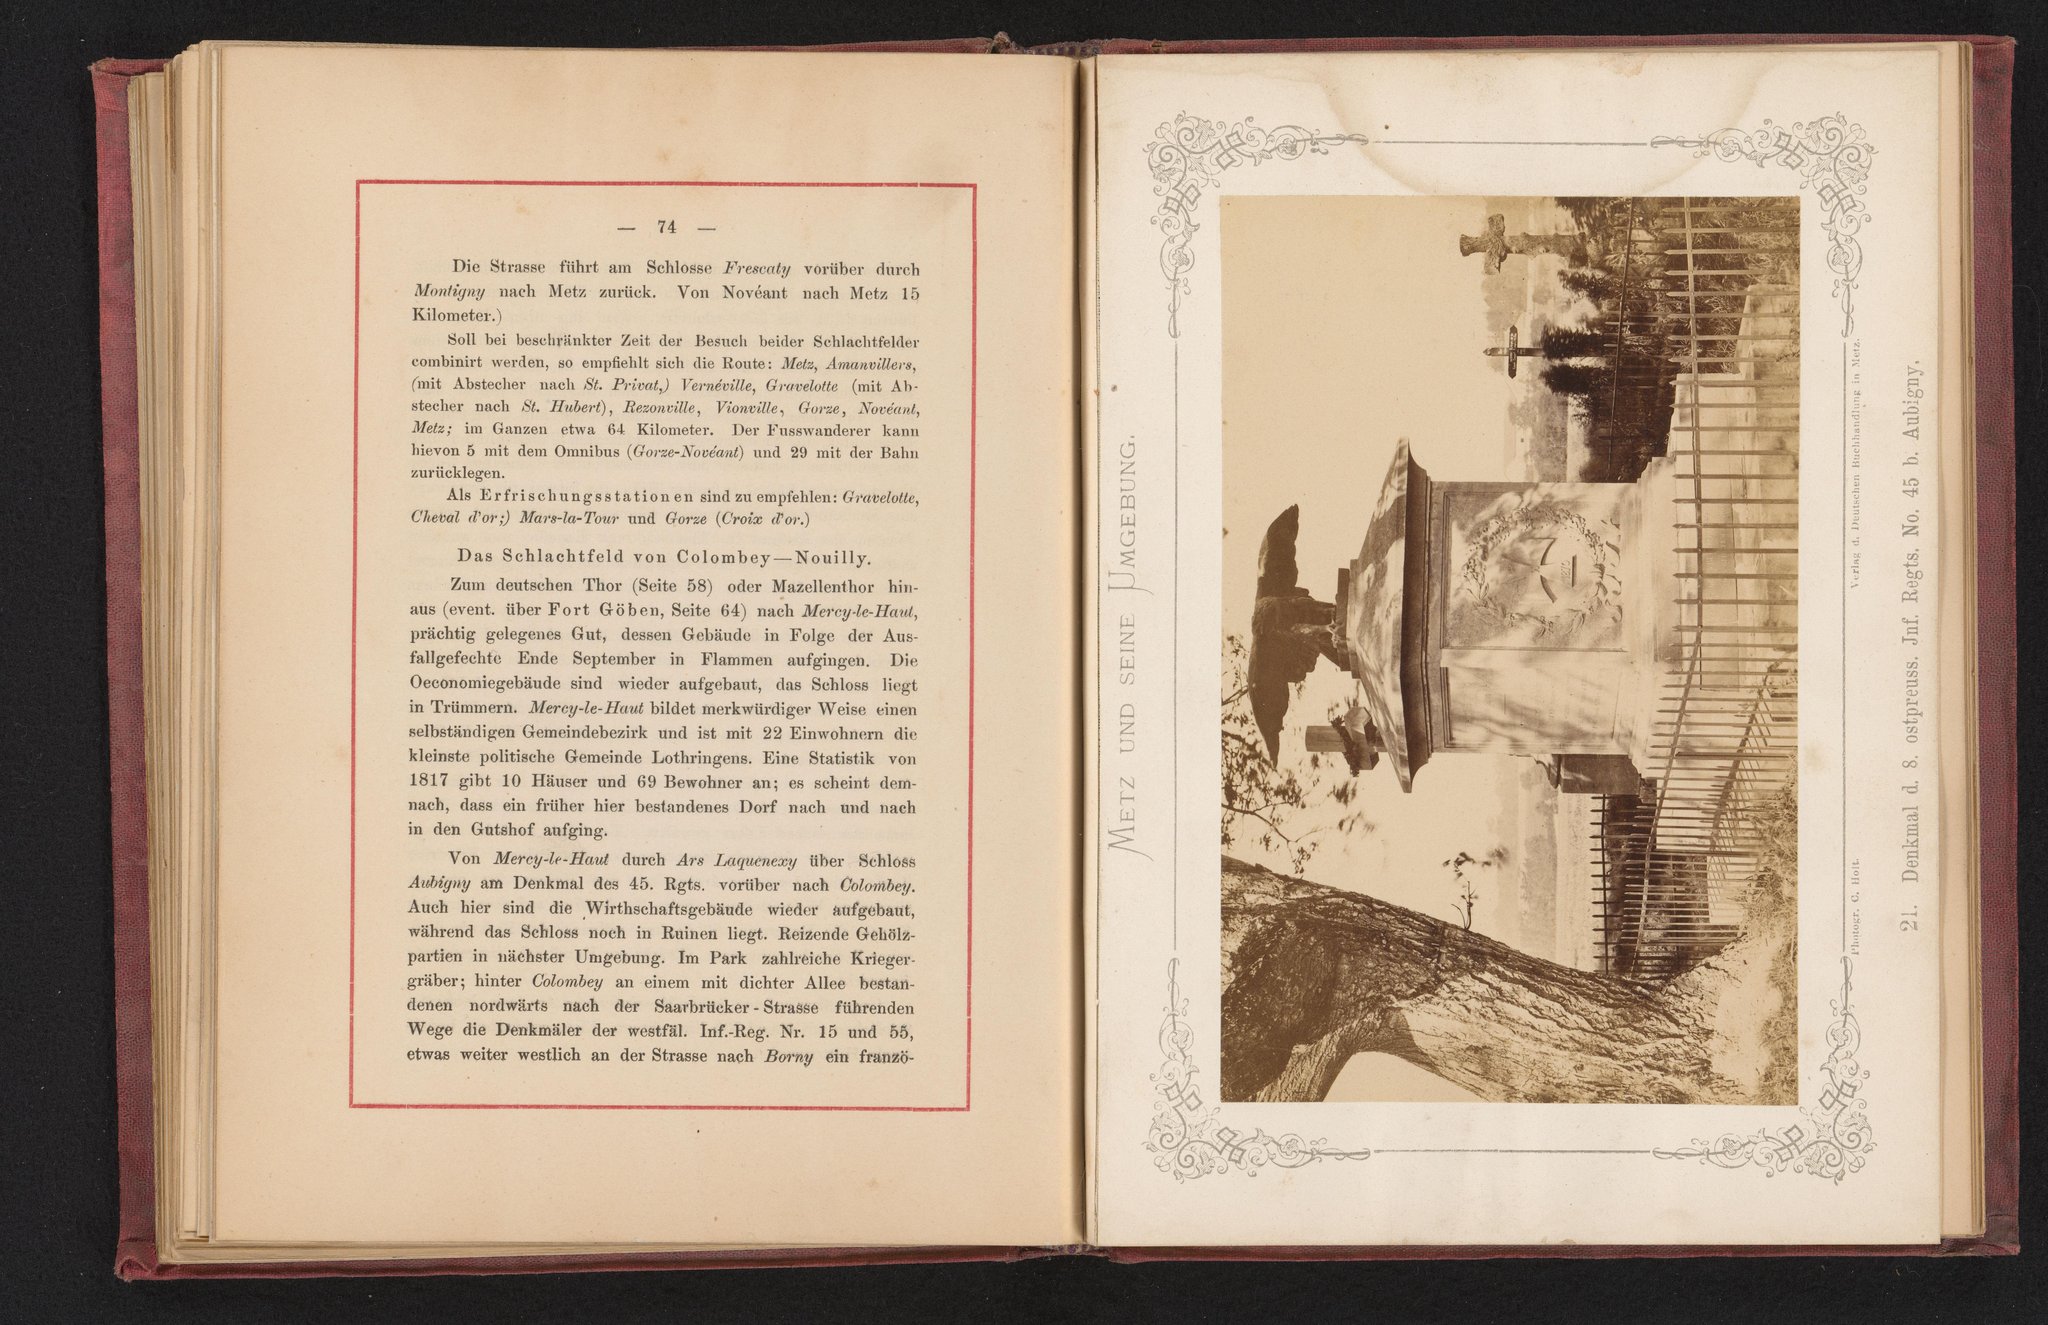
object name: page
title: Metz und seine Umgebung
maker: c. holt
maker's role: fotograaf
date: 1870-1875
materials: photographic support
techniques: albumen print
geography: metz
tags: monument, statue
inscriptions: number: ‘21.’